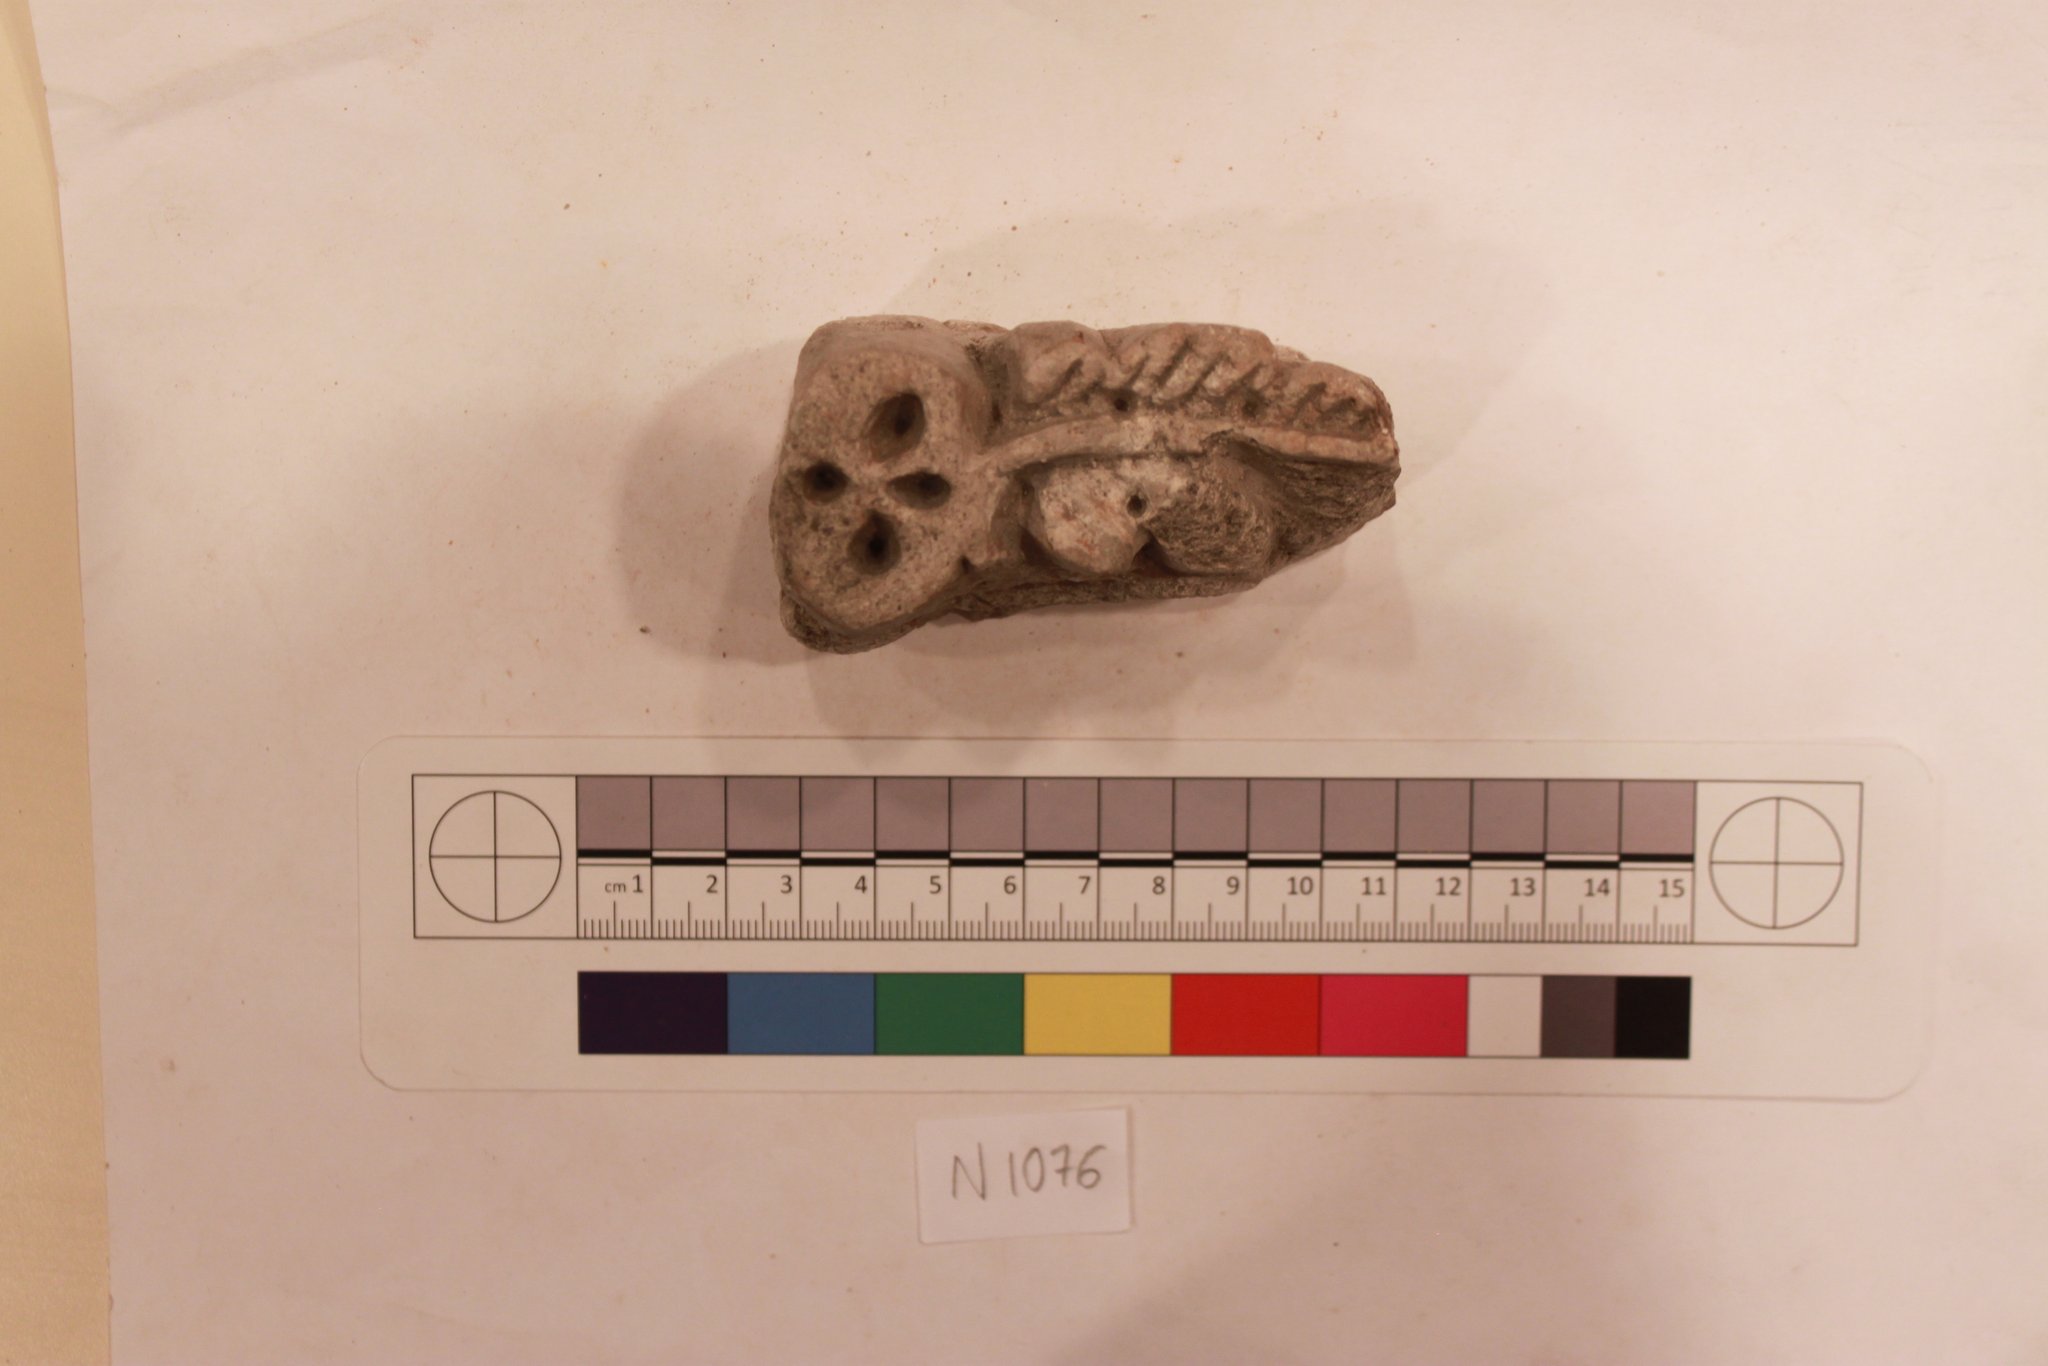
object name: fragment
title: Stucco Fragment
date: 701-1200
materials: plaster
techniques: carving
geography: iran